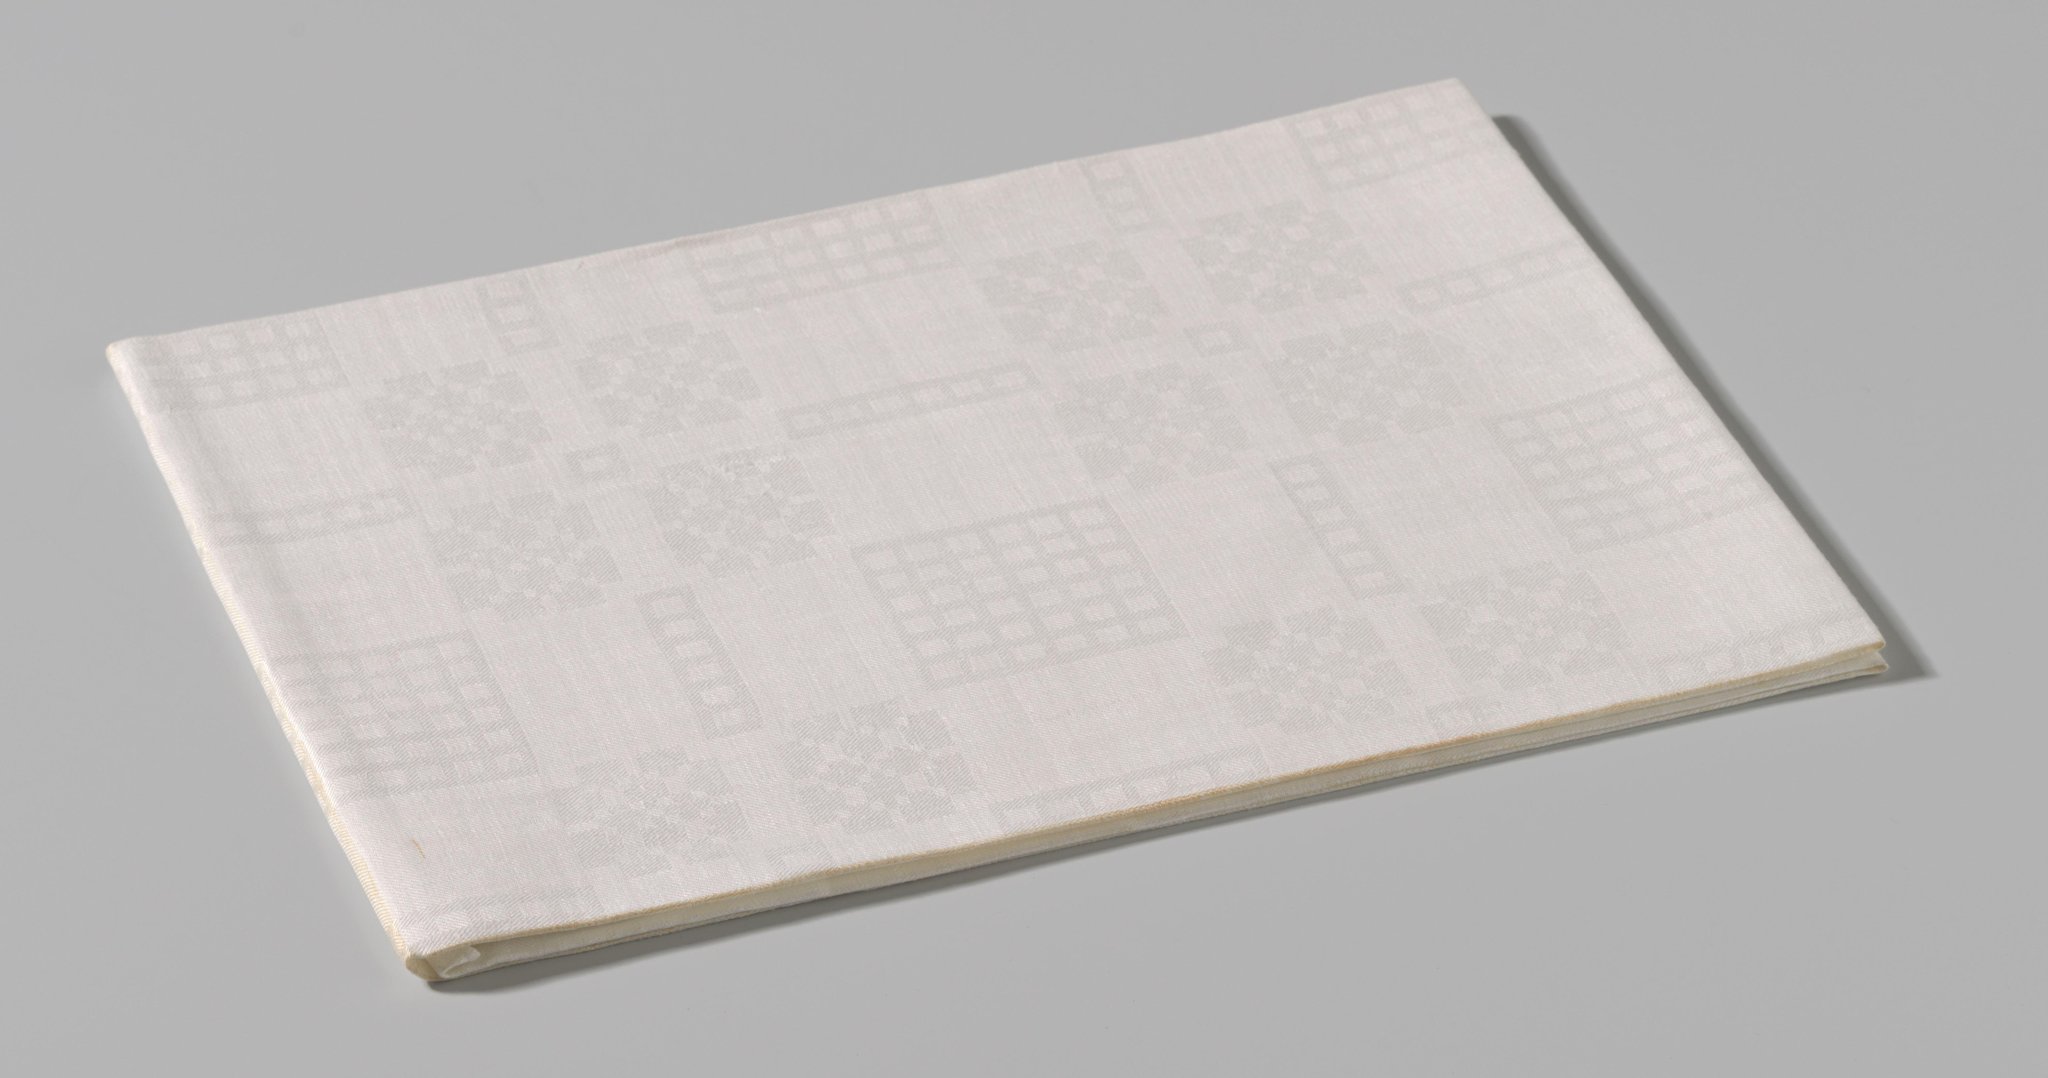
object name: napkin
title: Servet met pellenpatroon met wafelruit en bloemvorm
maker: Anonymous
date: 1675-1725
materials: linen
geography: northern netherlands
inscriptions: mark: ‘48’, mark: ‘BS’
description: Servet van wit linnen met een pellen patroon in keper, een wafelruitje met een soort bloem, merk BS en 48.